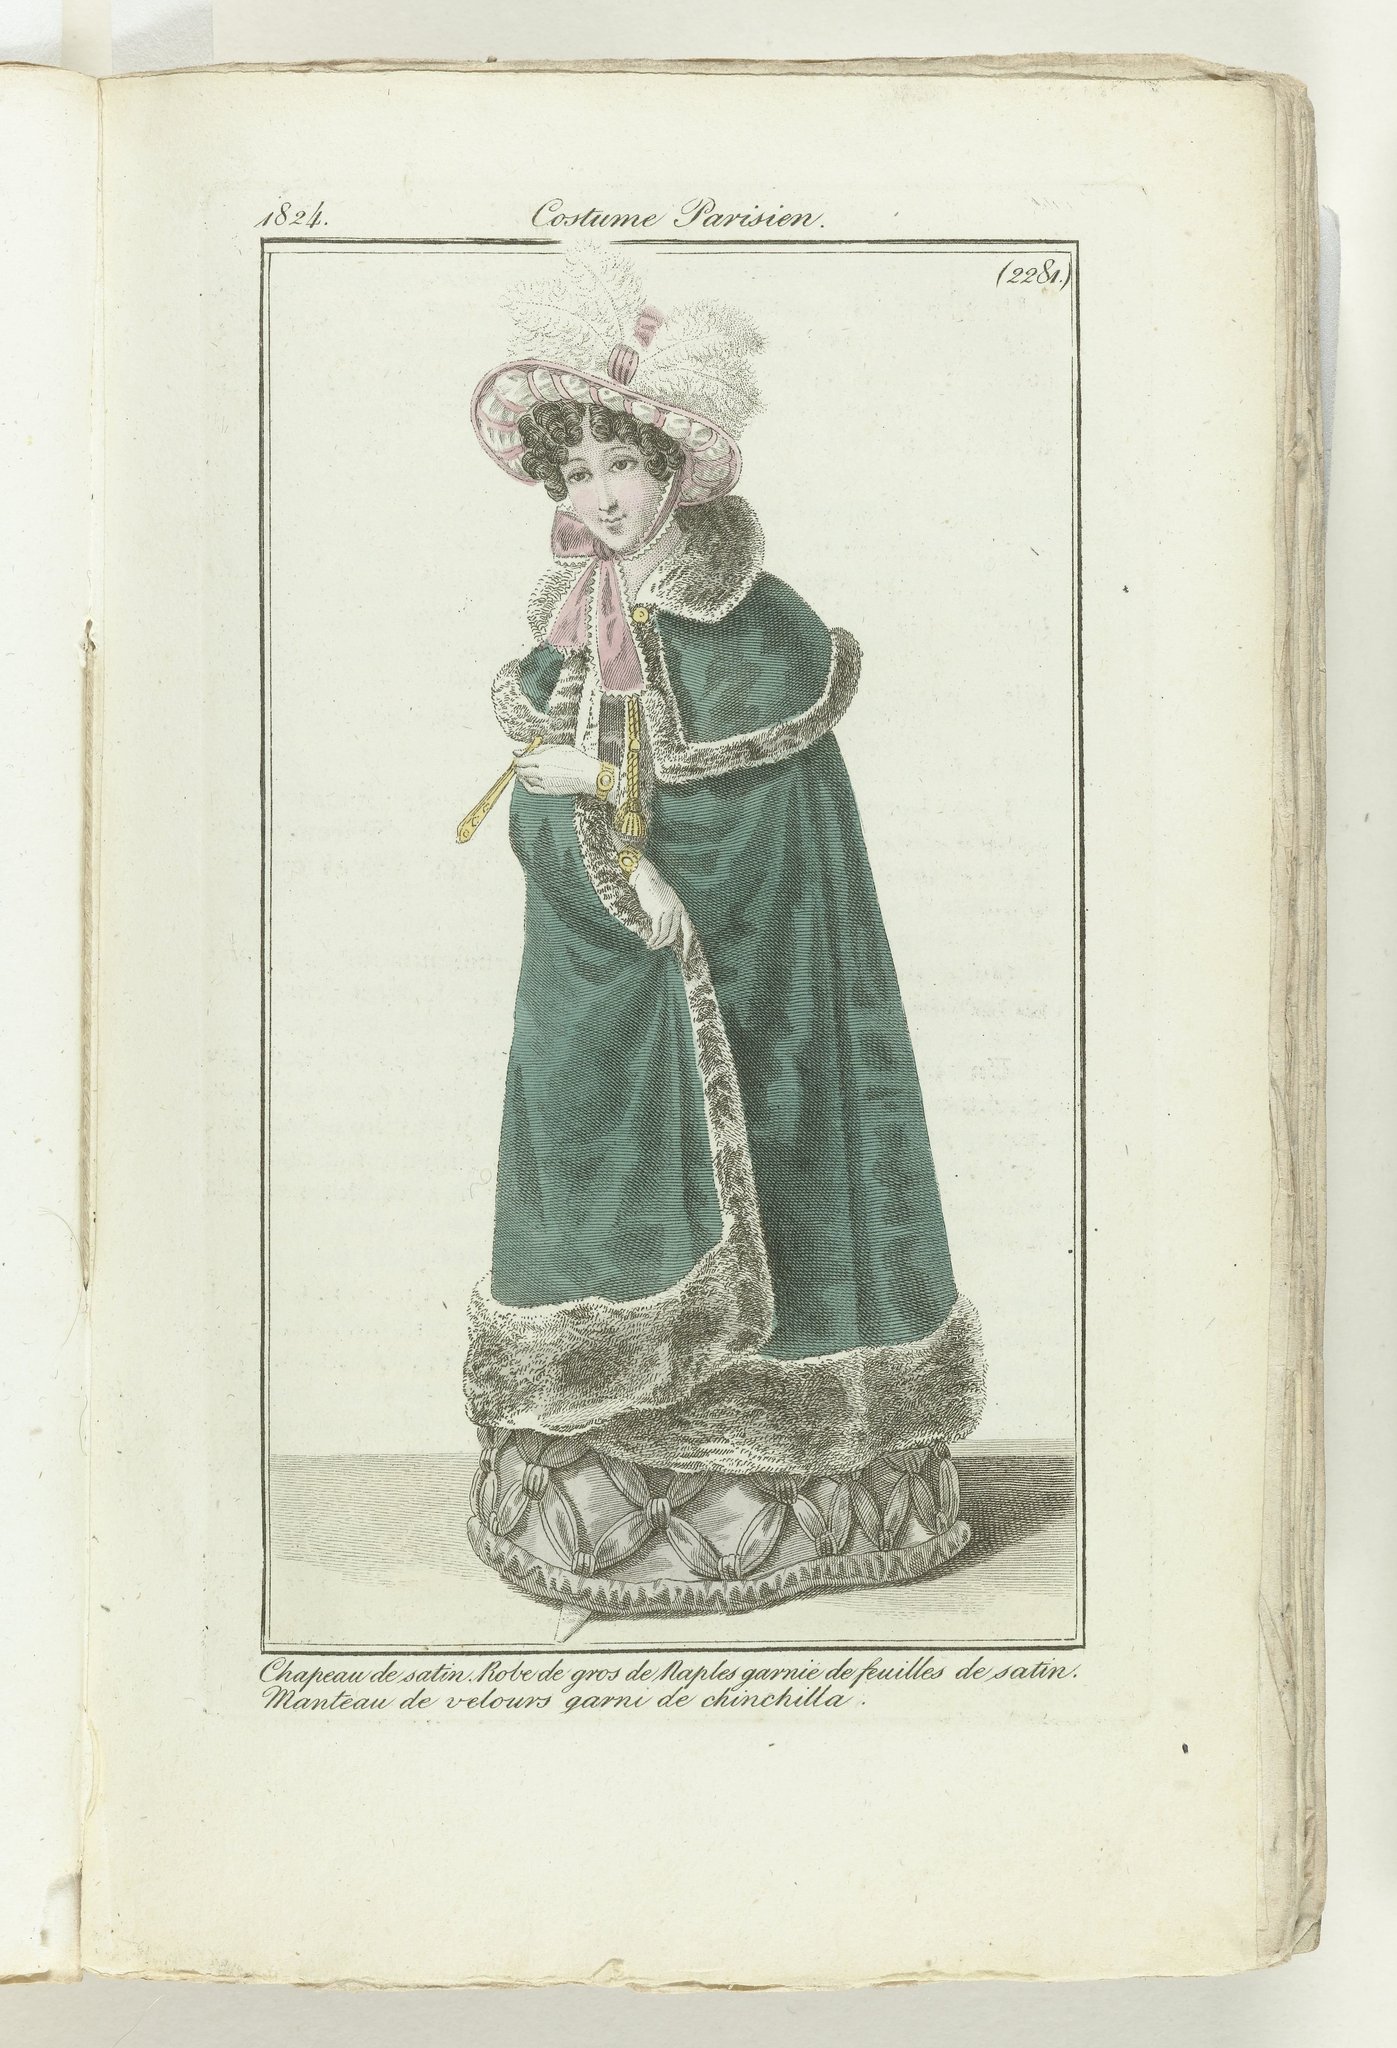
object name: fashion print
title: Journal des Dames et des Modes 1824, Costume Parisien (2281)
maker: Anonymous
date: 1824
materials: paper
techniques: etching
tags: fashion plates, clothes, costume (+ women's clothes)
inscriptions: date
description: Prent uit het tijdschrift Journal des Dames et des Modes, 1824.